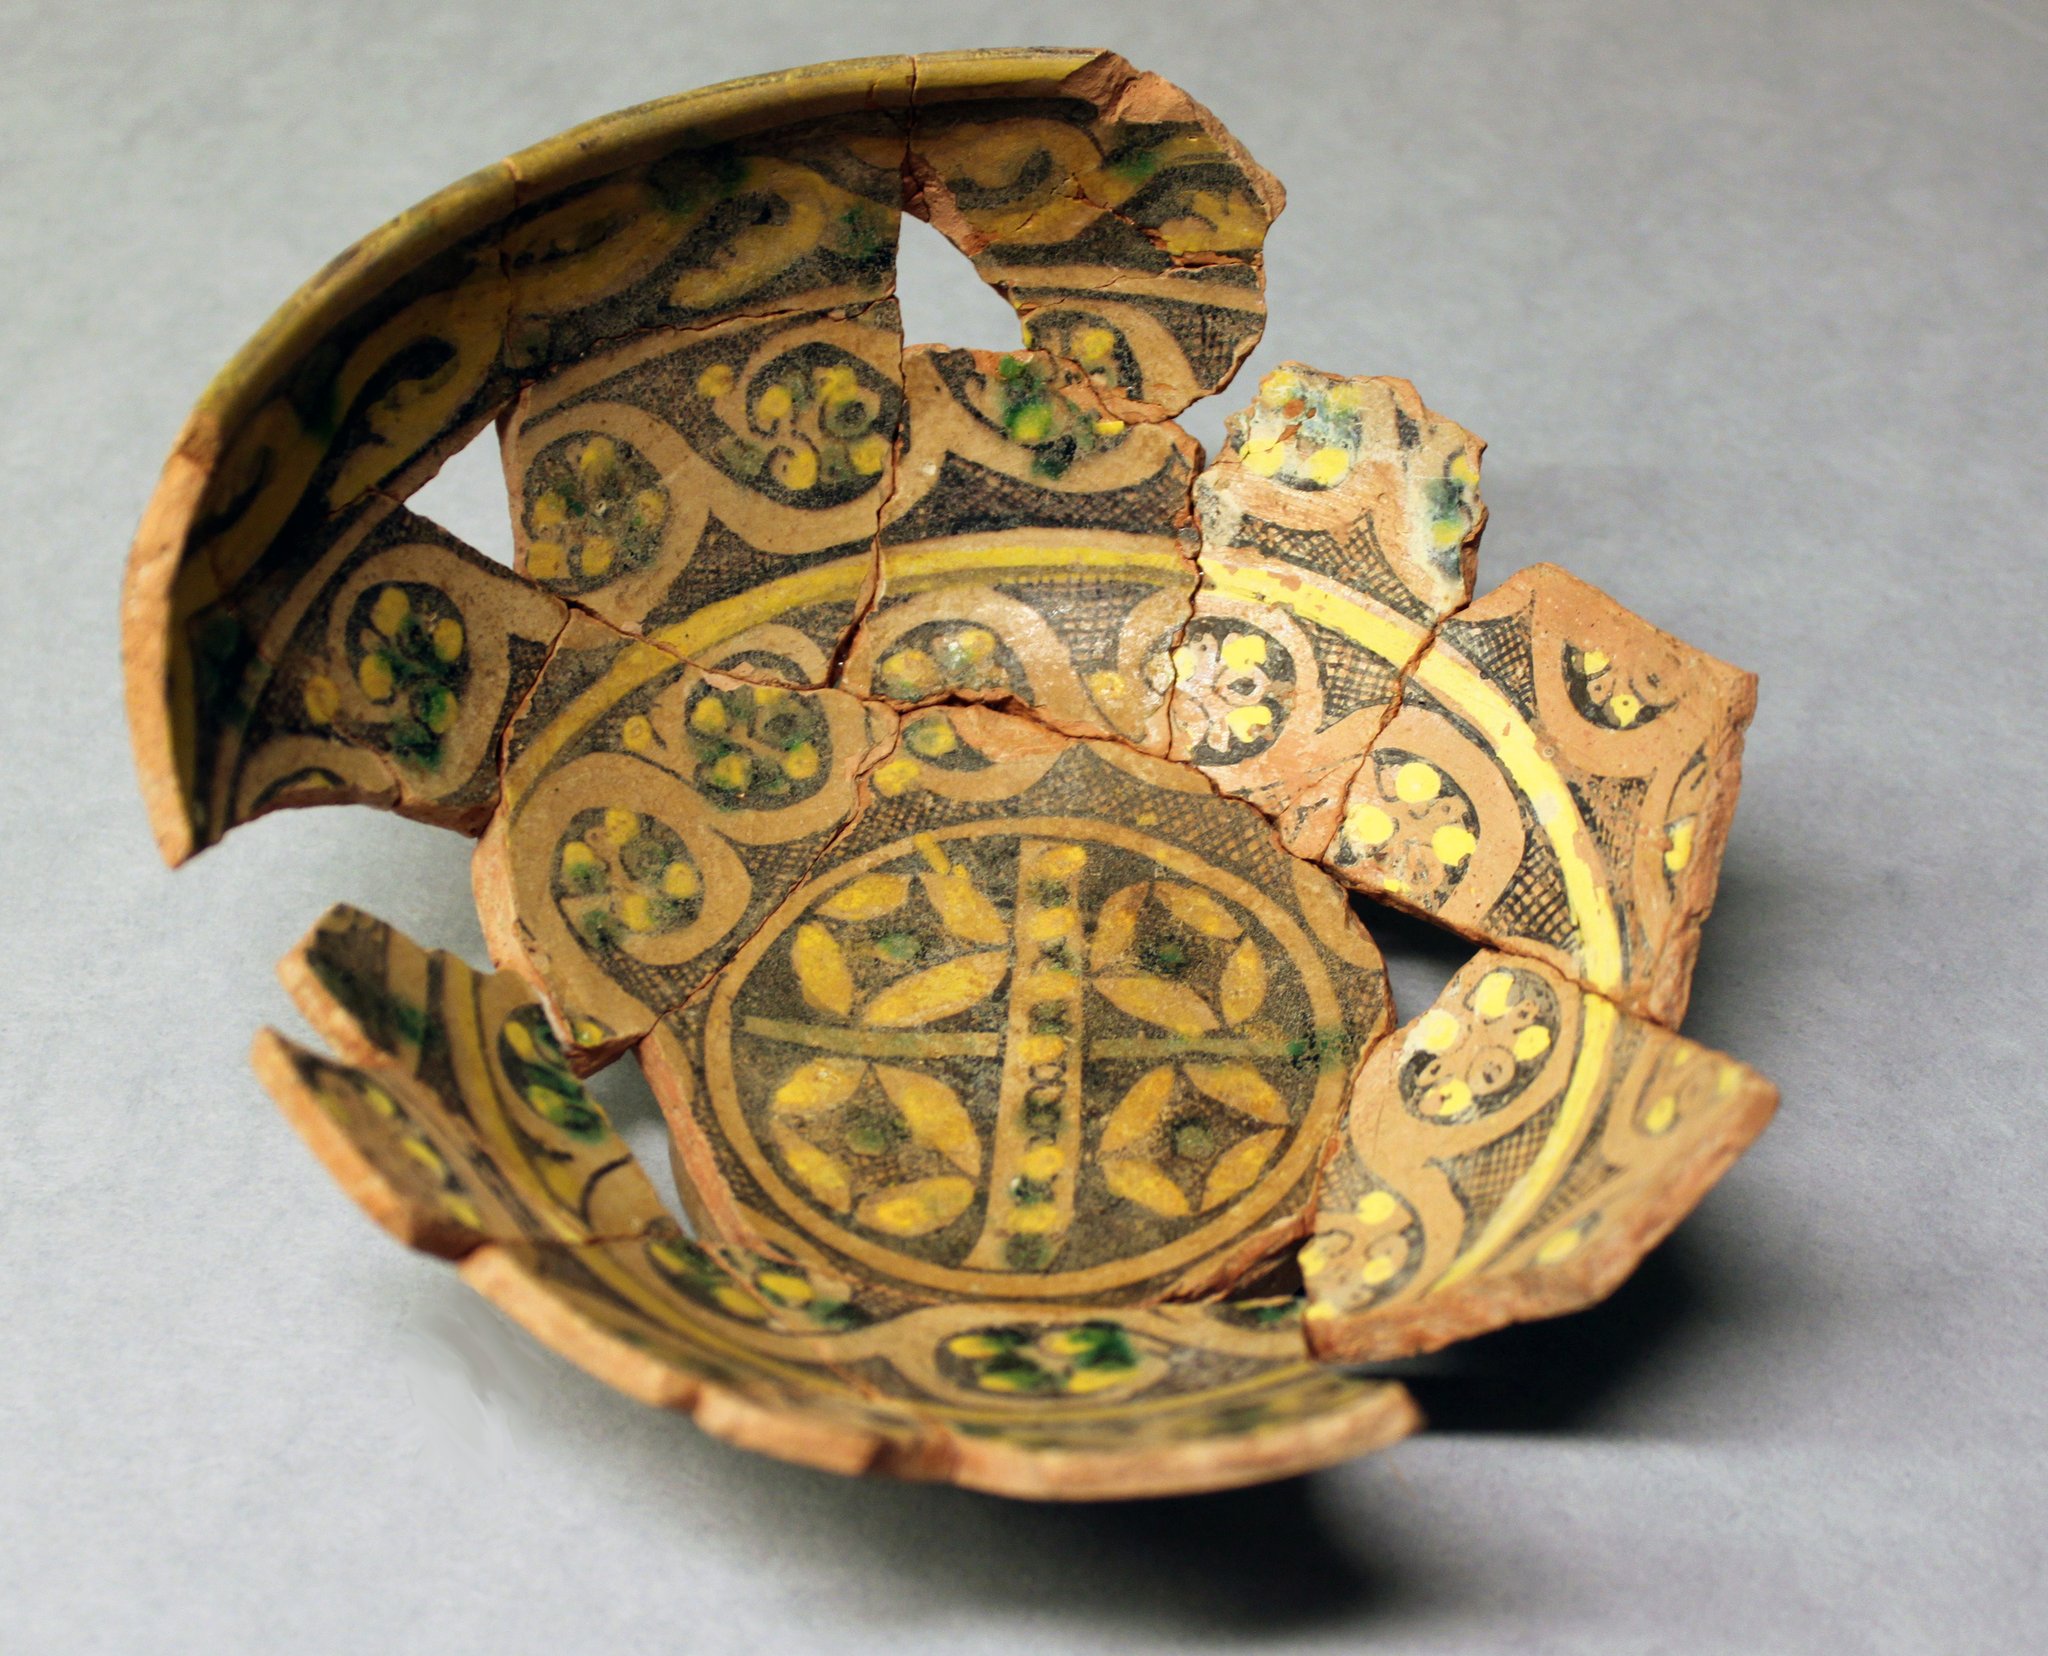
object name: bowl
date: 801-1000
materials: earthenware, glaze, pigment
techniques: painting, polychrome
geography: iran